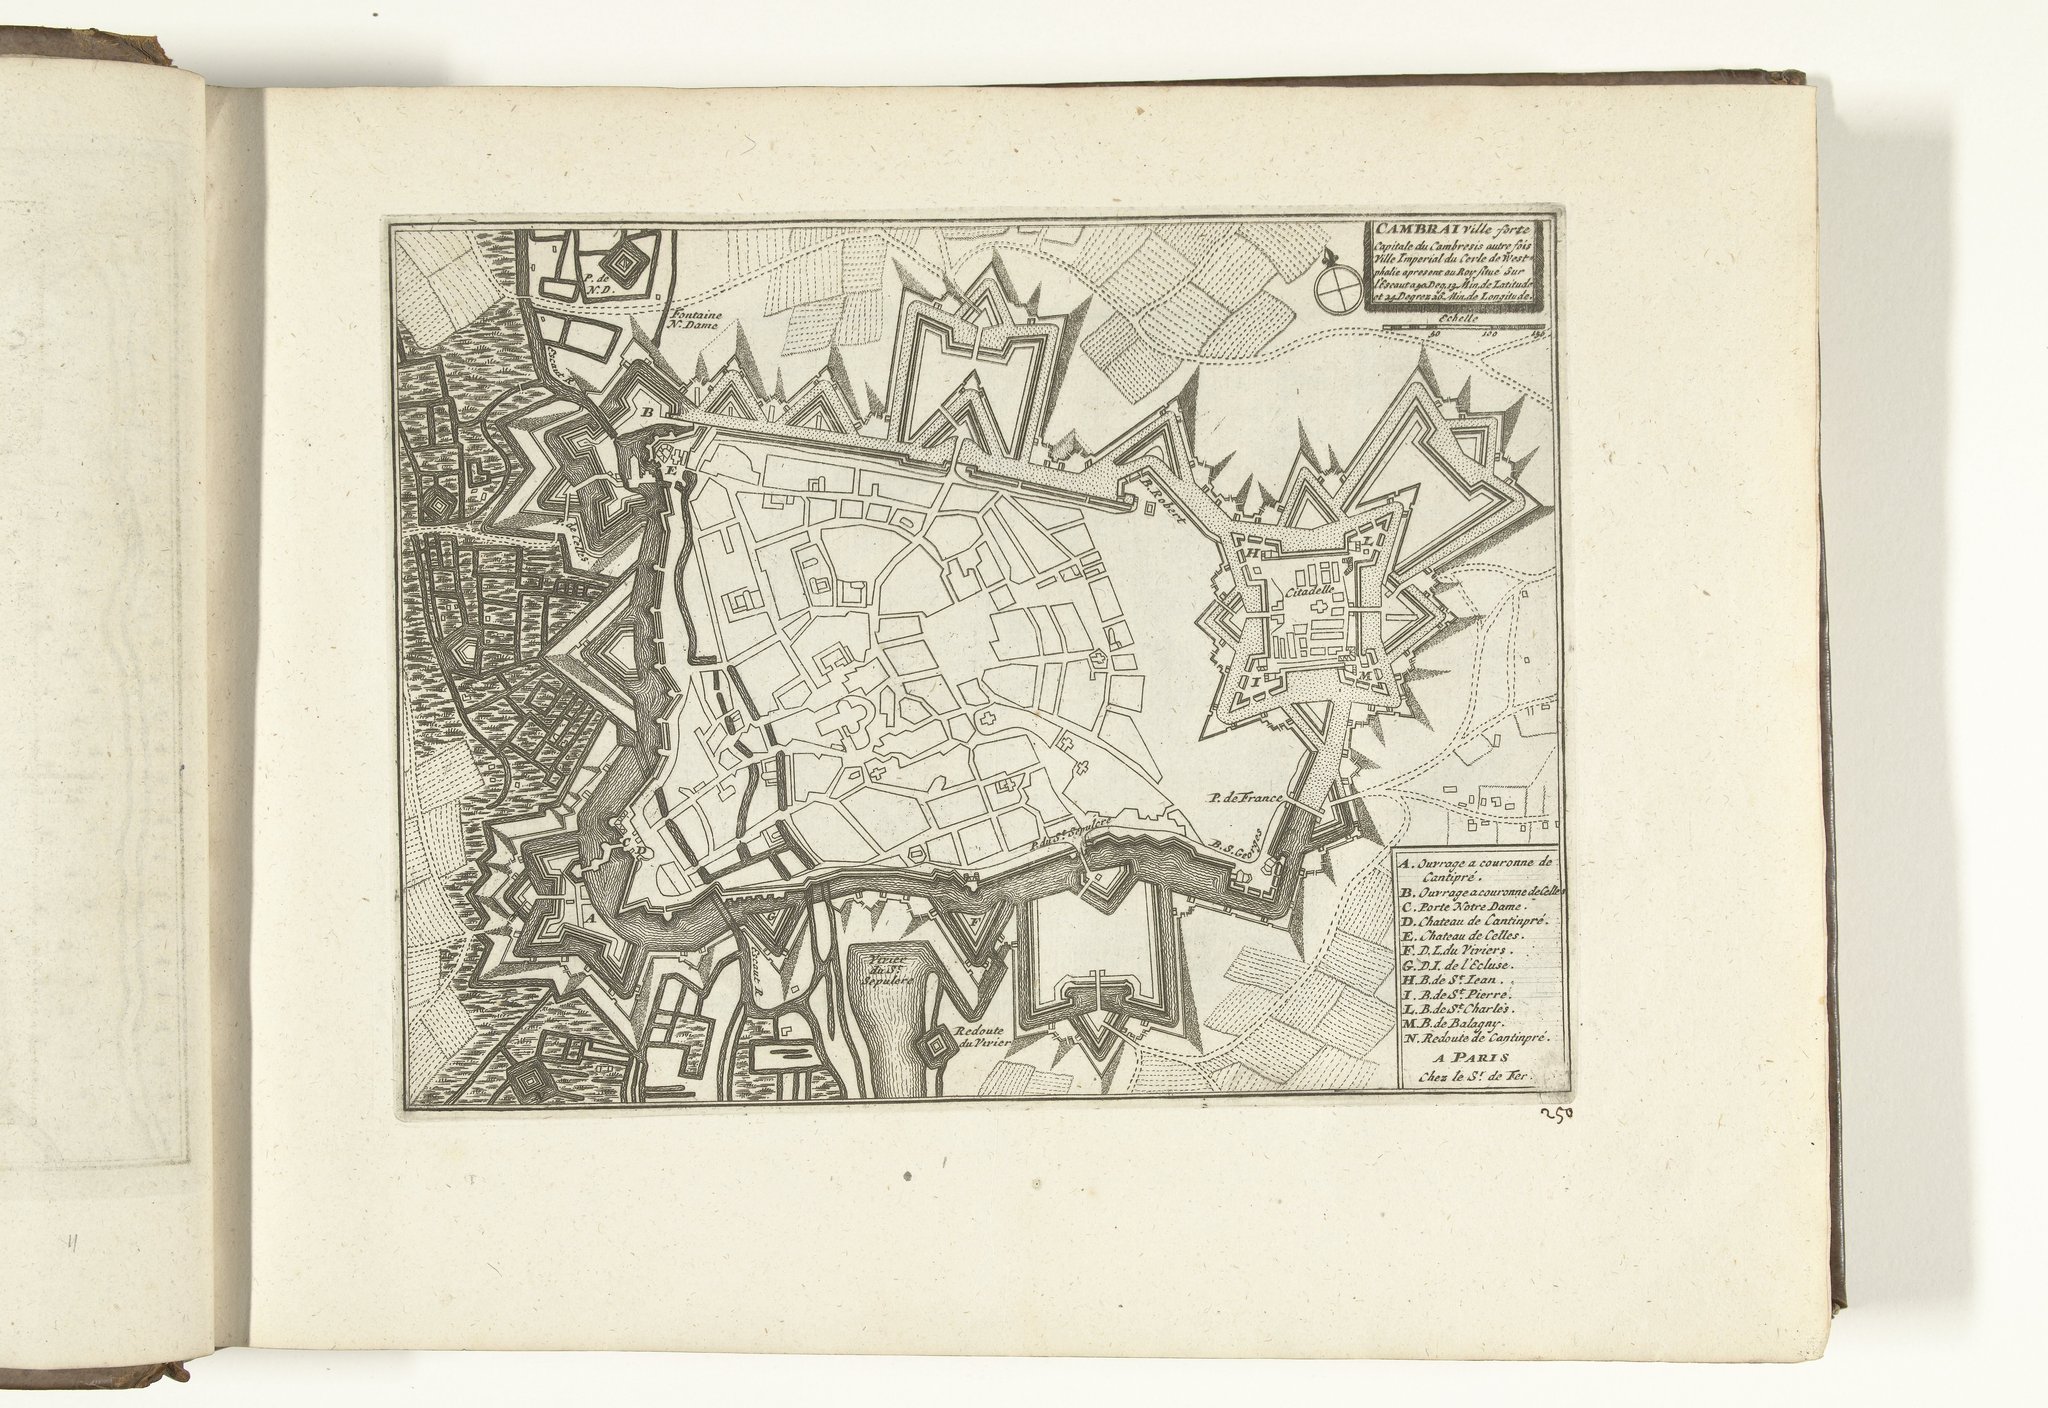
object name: map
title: Les Forces de l'Europe, Asie, Afrique et Amerique (...) Comme aussi les Cartes des Côtes de France et d'Espagne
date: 1726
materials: paper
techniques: etching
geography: leiden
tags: fortress, maps of cities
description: Plattegrond van de versterkingen om de stad Cambrai (Kamerijk). Plaat nr. 250 in deel XI van het prentwerk: Les Forces de l'Europe, Asie, Afrique et Amerique ... Comme aussi les Cartes des Côtes de France et d'Espagne uit 1726, dit tweede deel met 271 met de hand genummerde platen van vermaarde sterke steden en vestingen in het kader van de Spaanse Successieoorlog 1701-1713. Voor het merendeel zijn deze platen gekopieerd naar de anonieme Franse platen van vermaarde sterke steden en vestingen: in Les forces de l'Europe en in: Le theatre de la guerre, dans les Pays-Bas, beide oorspronkelijk uitgegeven door Nicolas de Fer te Parijs (1693-1697) in het kader van de Negenjarige Oorlog. Titel en opschriften in het Frans.